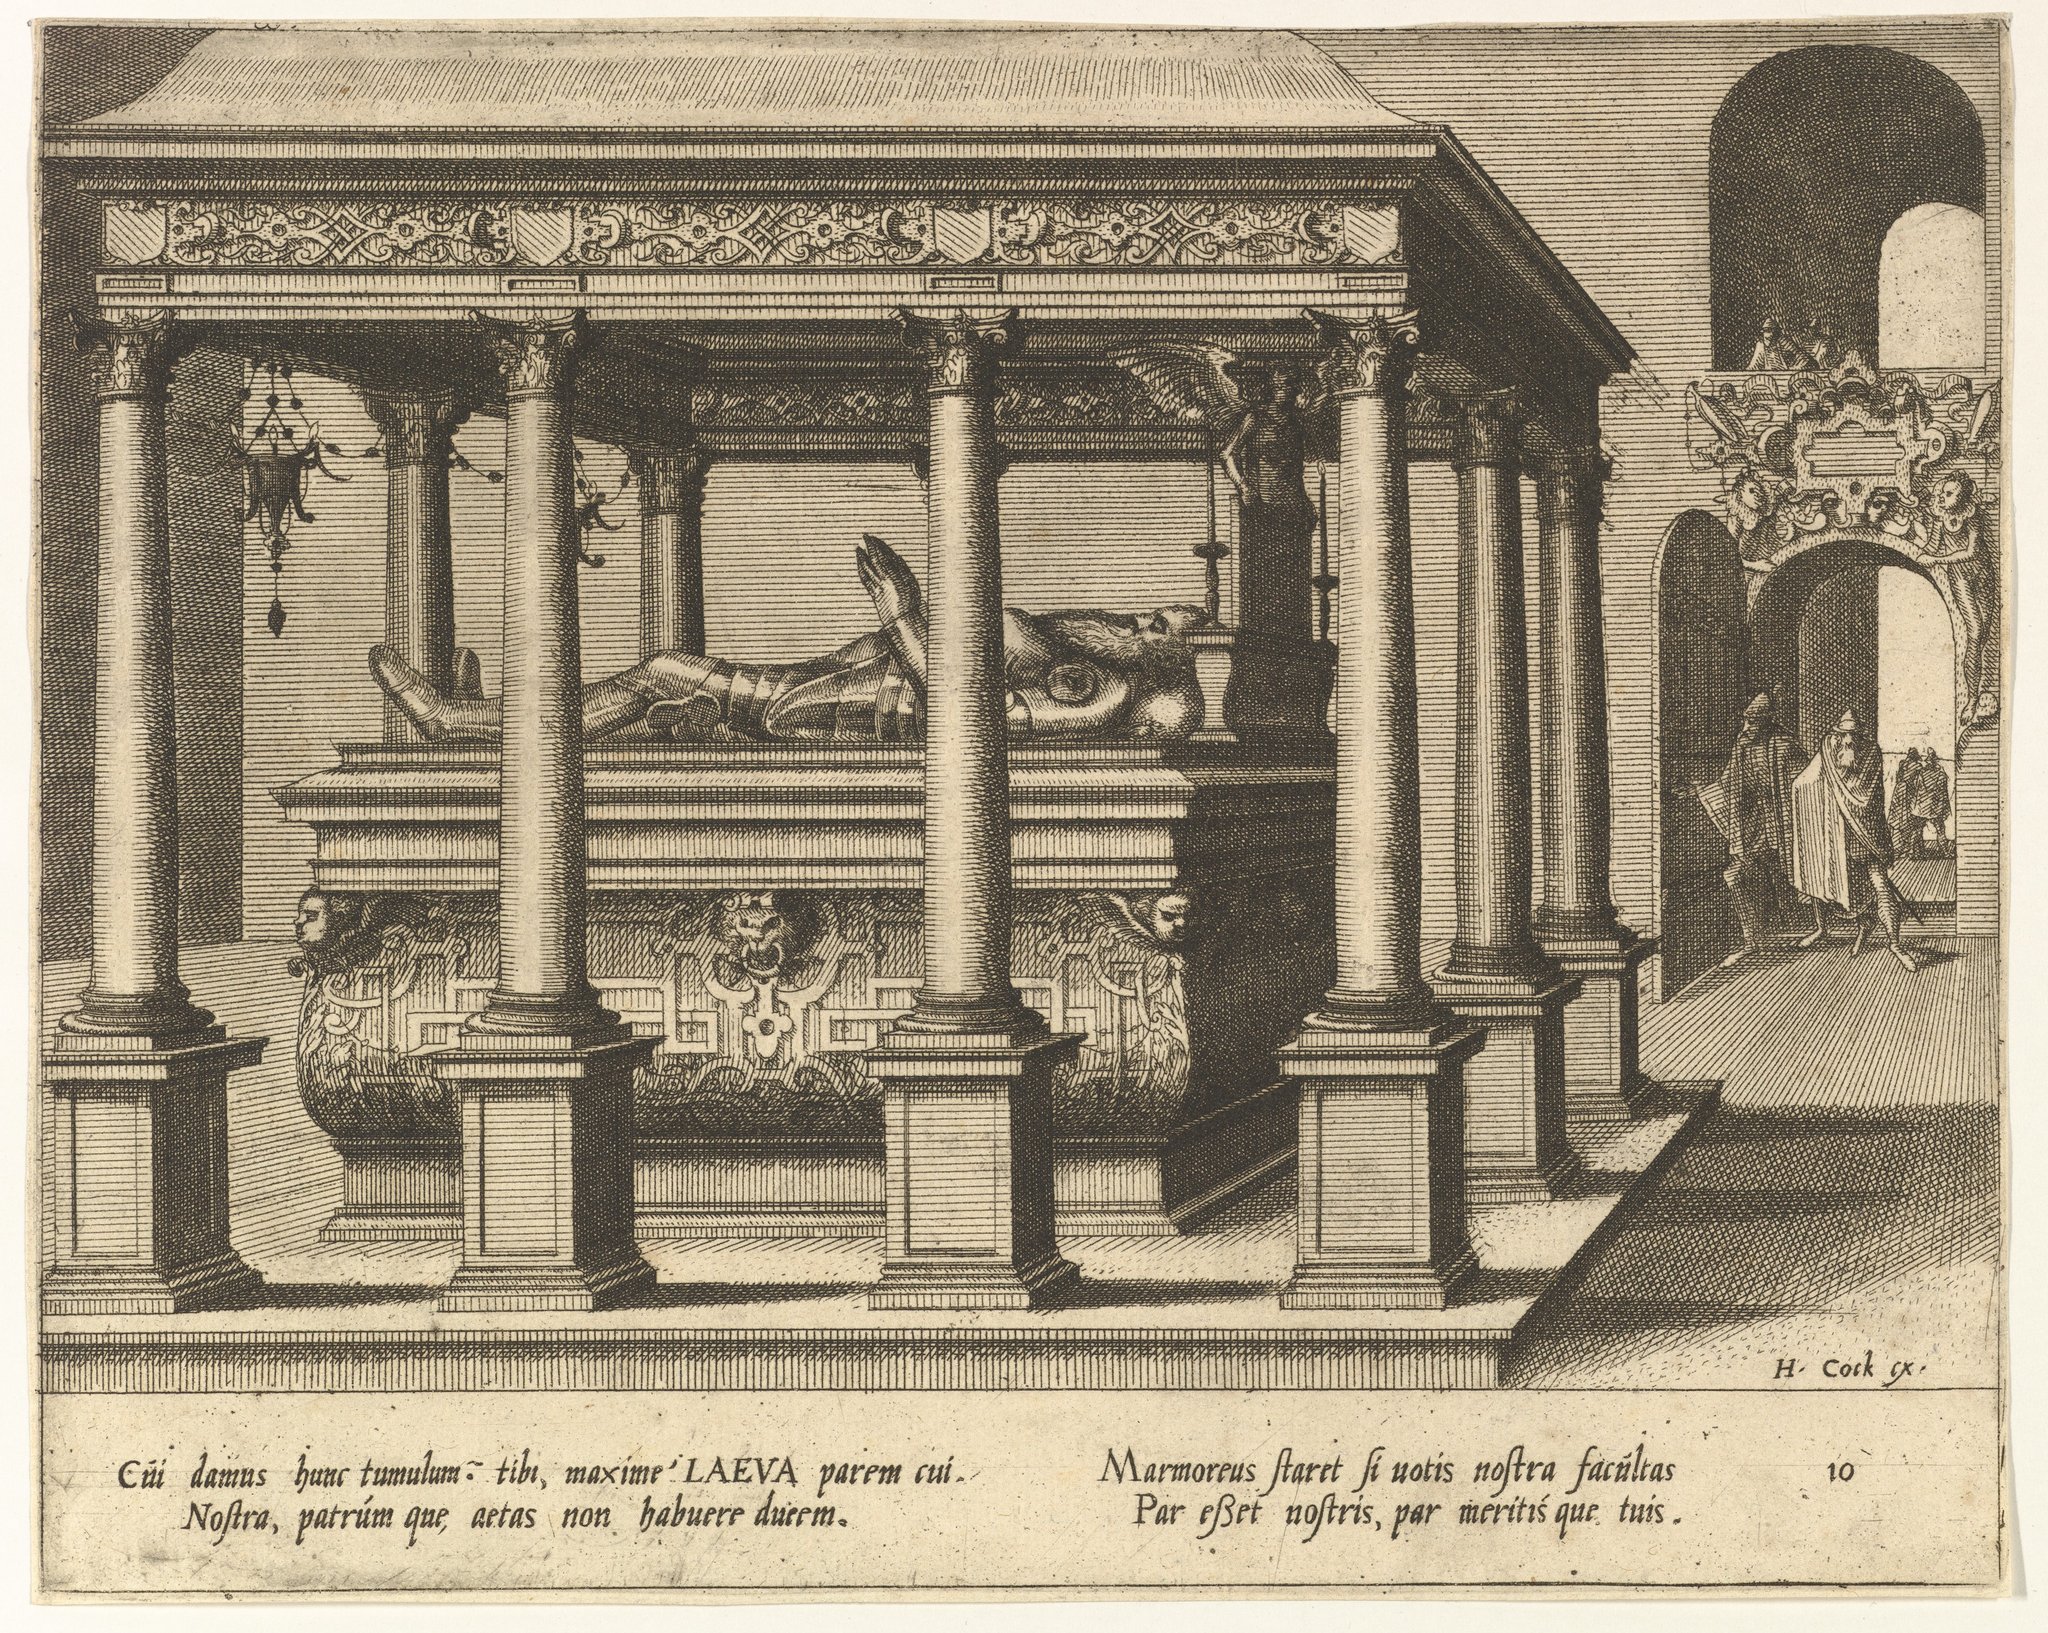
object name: collection ornament architecture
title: Cœnotaphiorum (10)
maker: hans vredeman de vries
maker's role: artist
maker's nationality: netherlandish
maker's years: 1527-1606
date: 1563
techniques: etching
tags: columns,tombs,men